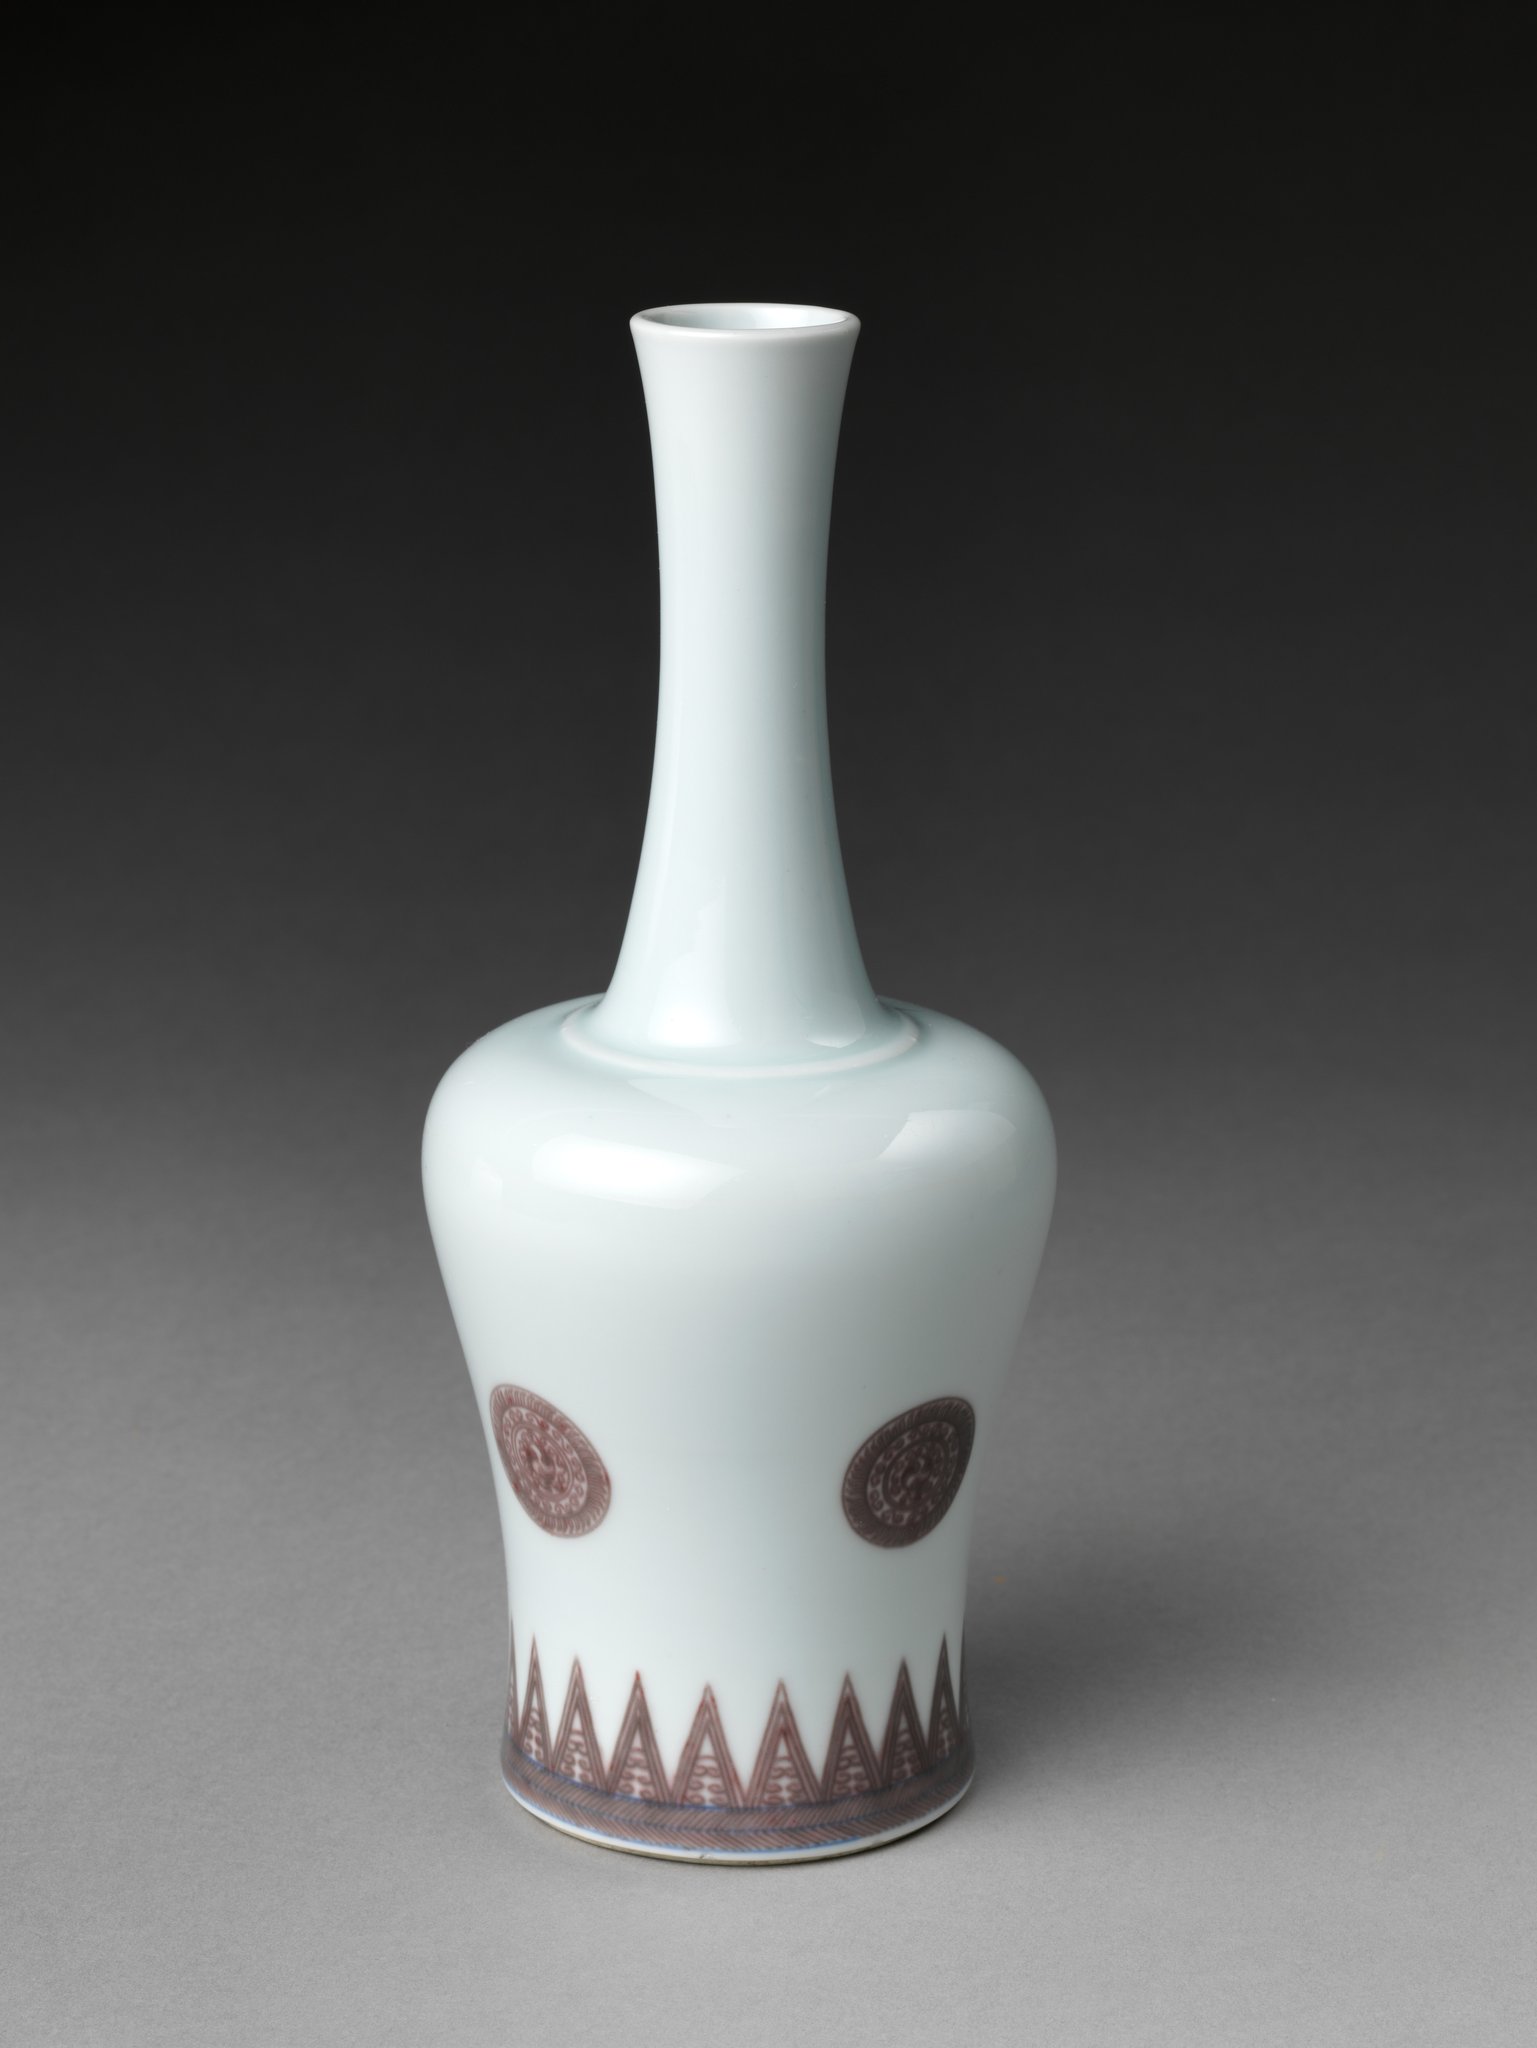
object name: bottle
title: Bottle with Stylized Rosette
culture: chinese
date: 1713-1722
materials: copper, glaze, porcelain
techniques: painting